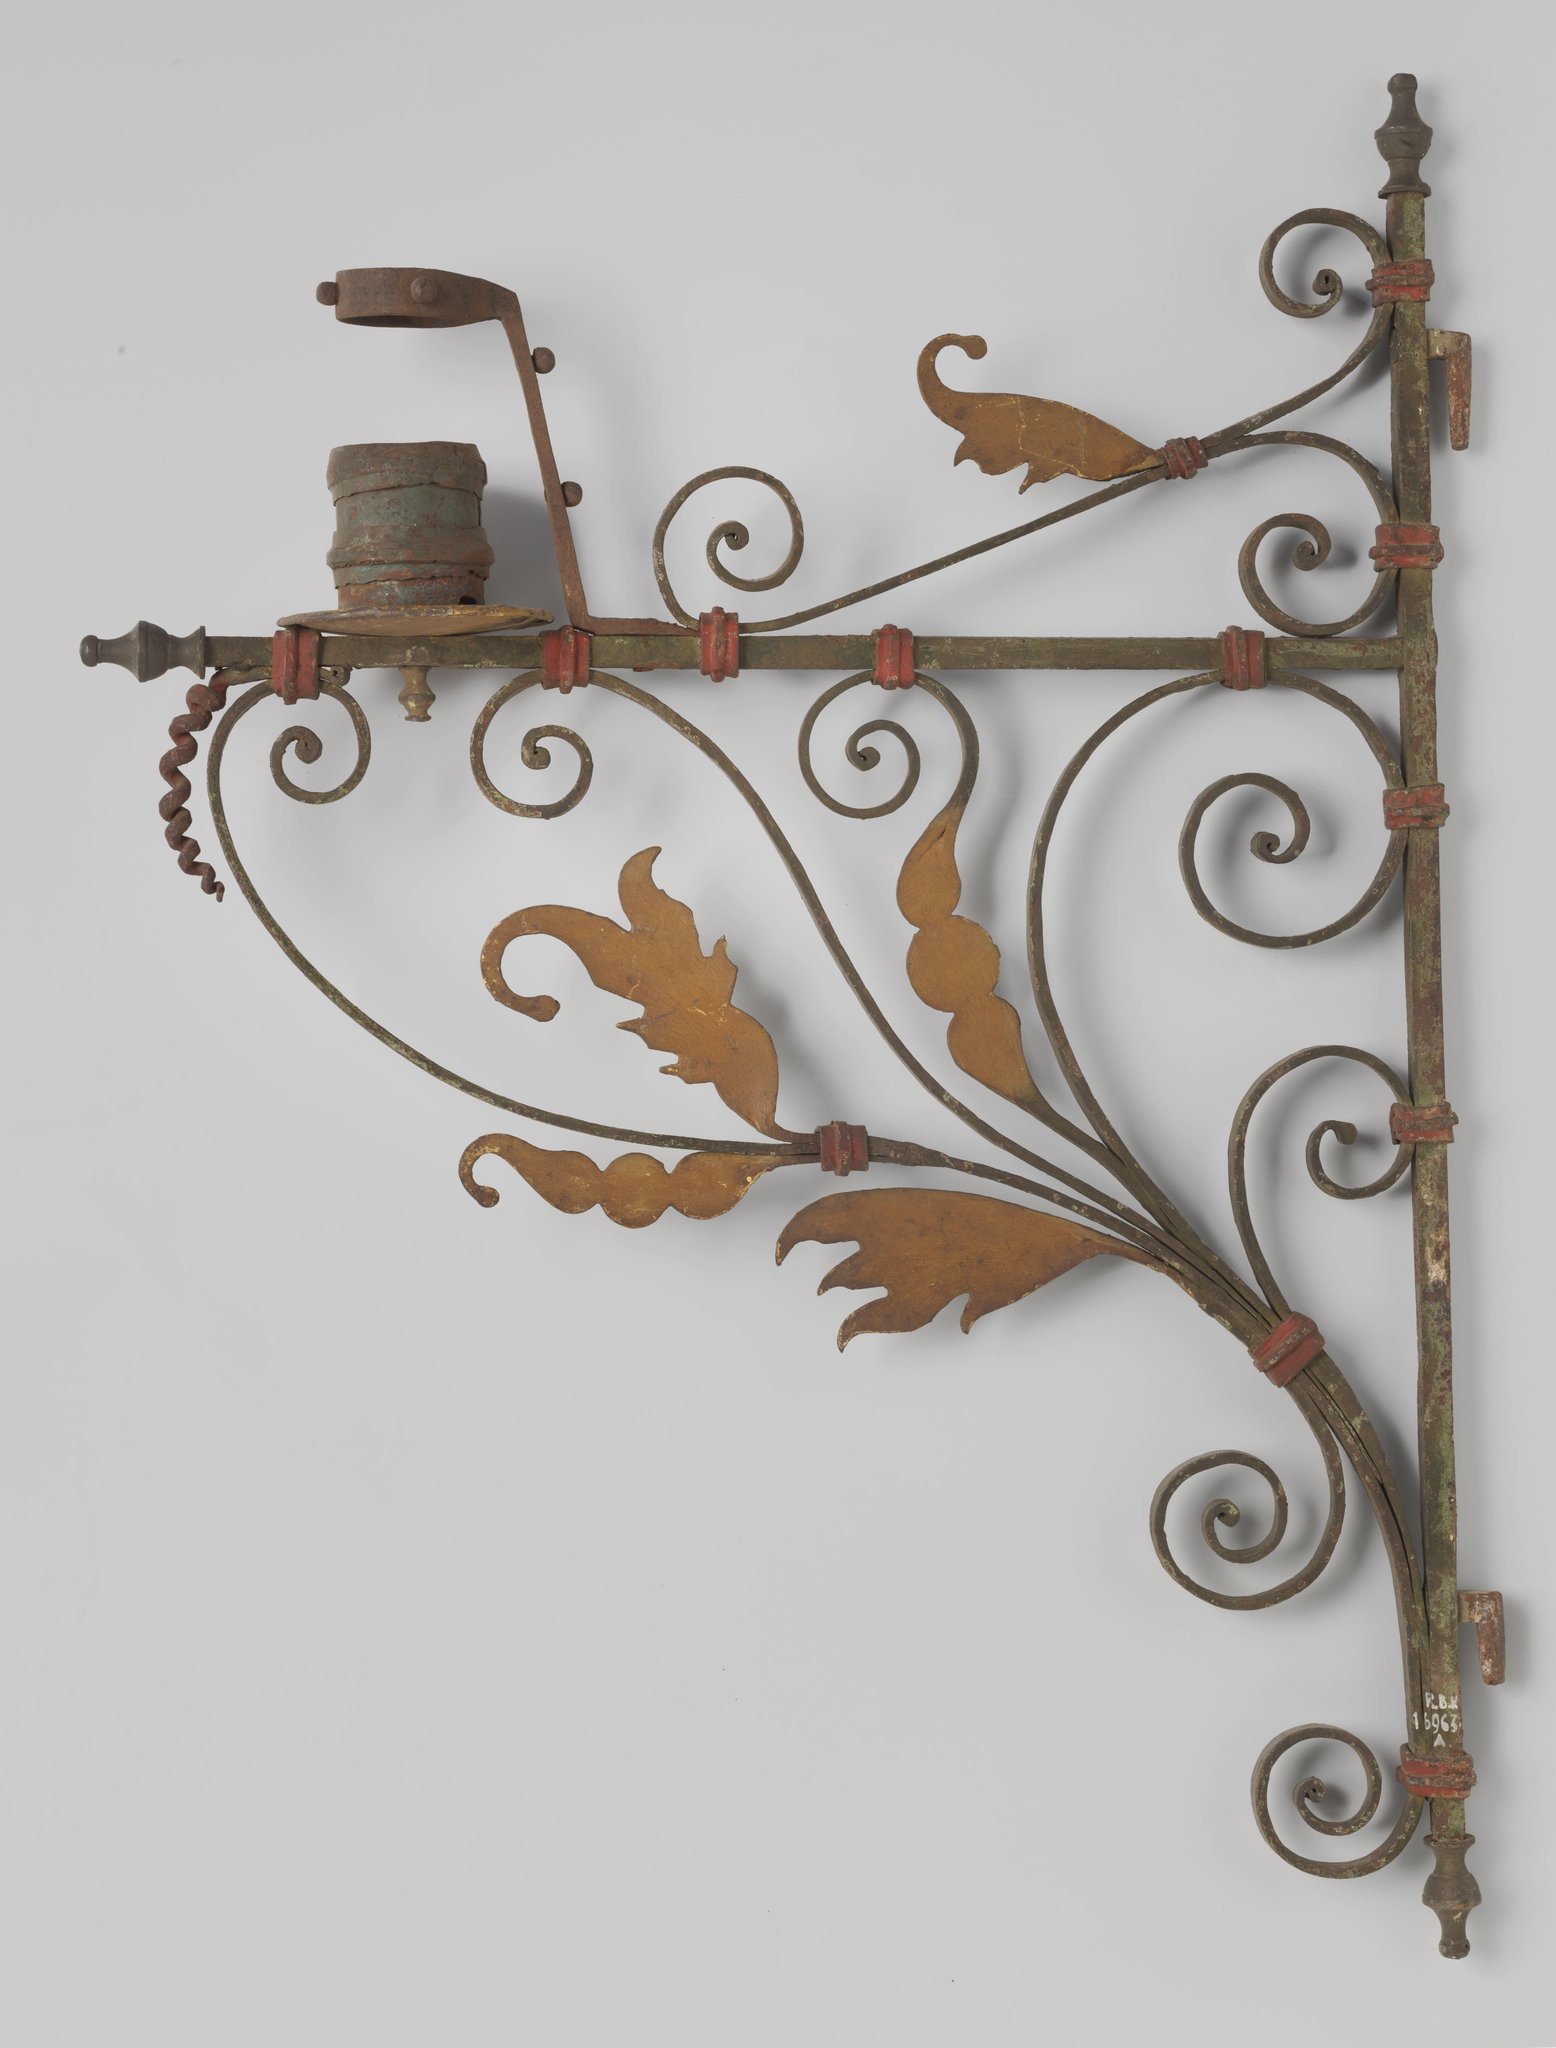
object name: uithangarm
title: Uithangarm, verz. Mannheimer.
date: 1700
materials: bronze, iron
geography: italy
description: Een ijzeren uithangarm bestaande uit een verticale en een daarop loodrecht geplaatste horizontale vierzijdige stang waarvan de uiteinden zijn voorzien van geprofileerde knoppen. Op het einde van de horizontale stang een brons kaarsenhouder (?) en een afhangend spiraal. De ongelijke hoekruimten worden onderaan gevuld met een soort rank gevormd uit samengebundelde voluten waaraan enige bladeren; de bovenruimte door een trekstang met drie voluten en een blad. Afkomstig uit de verzameling Dr. F. Mannheimer.